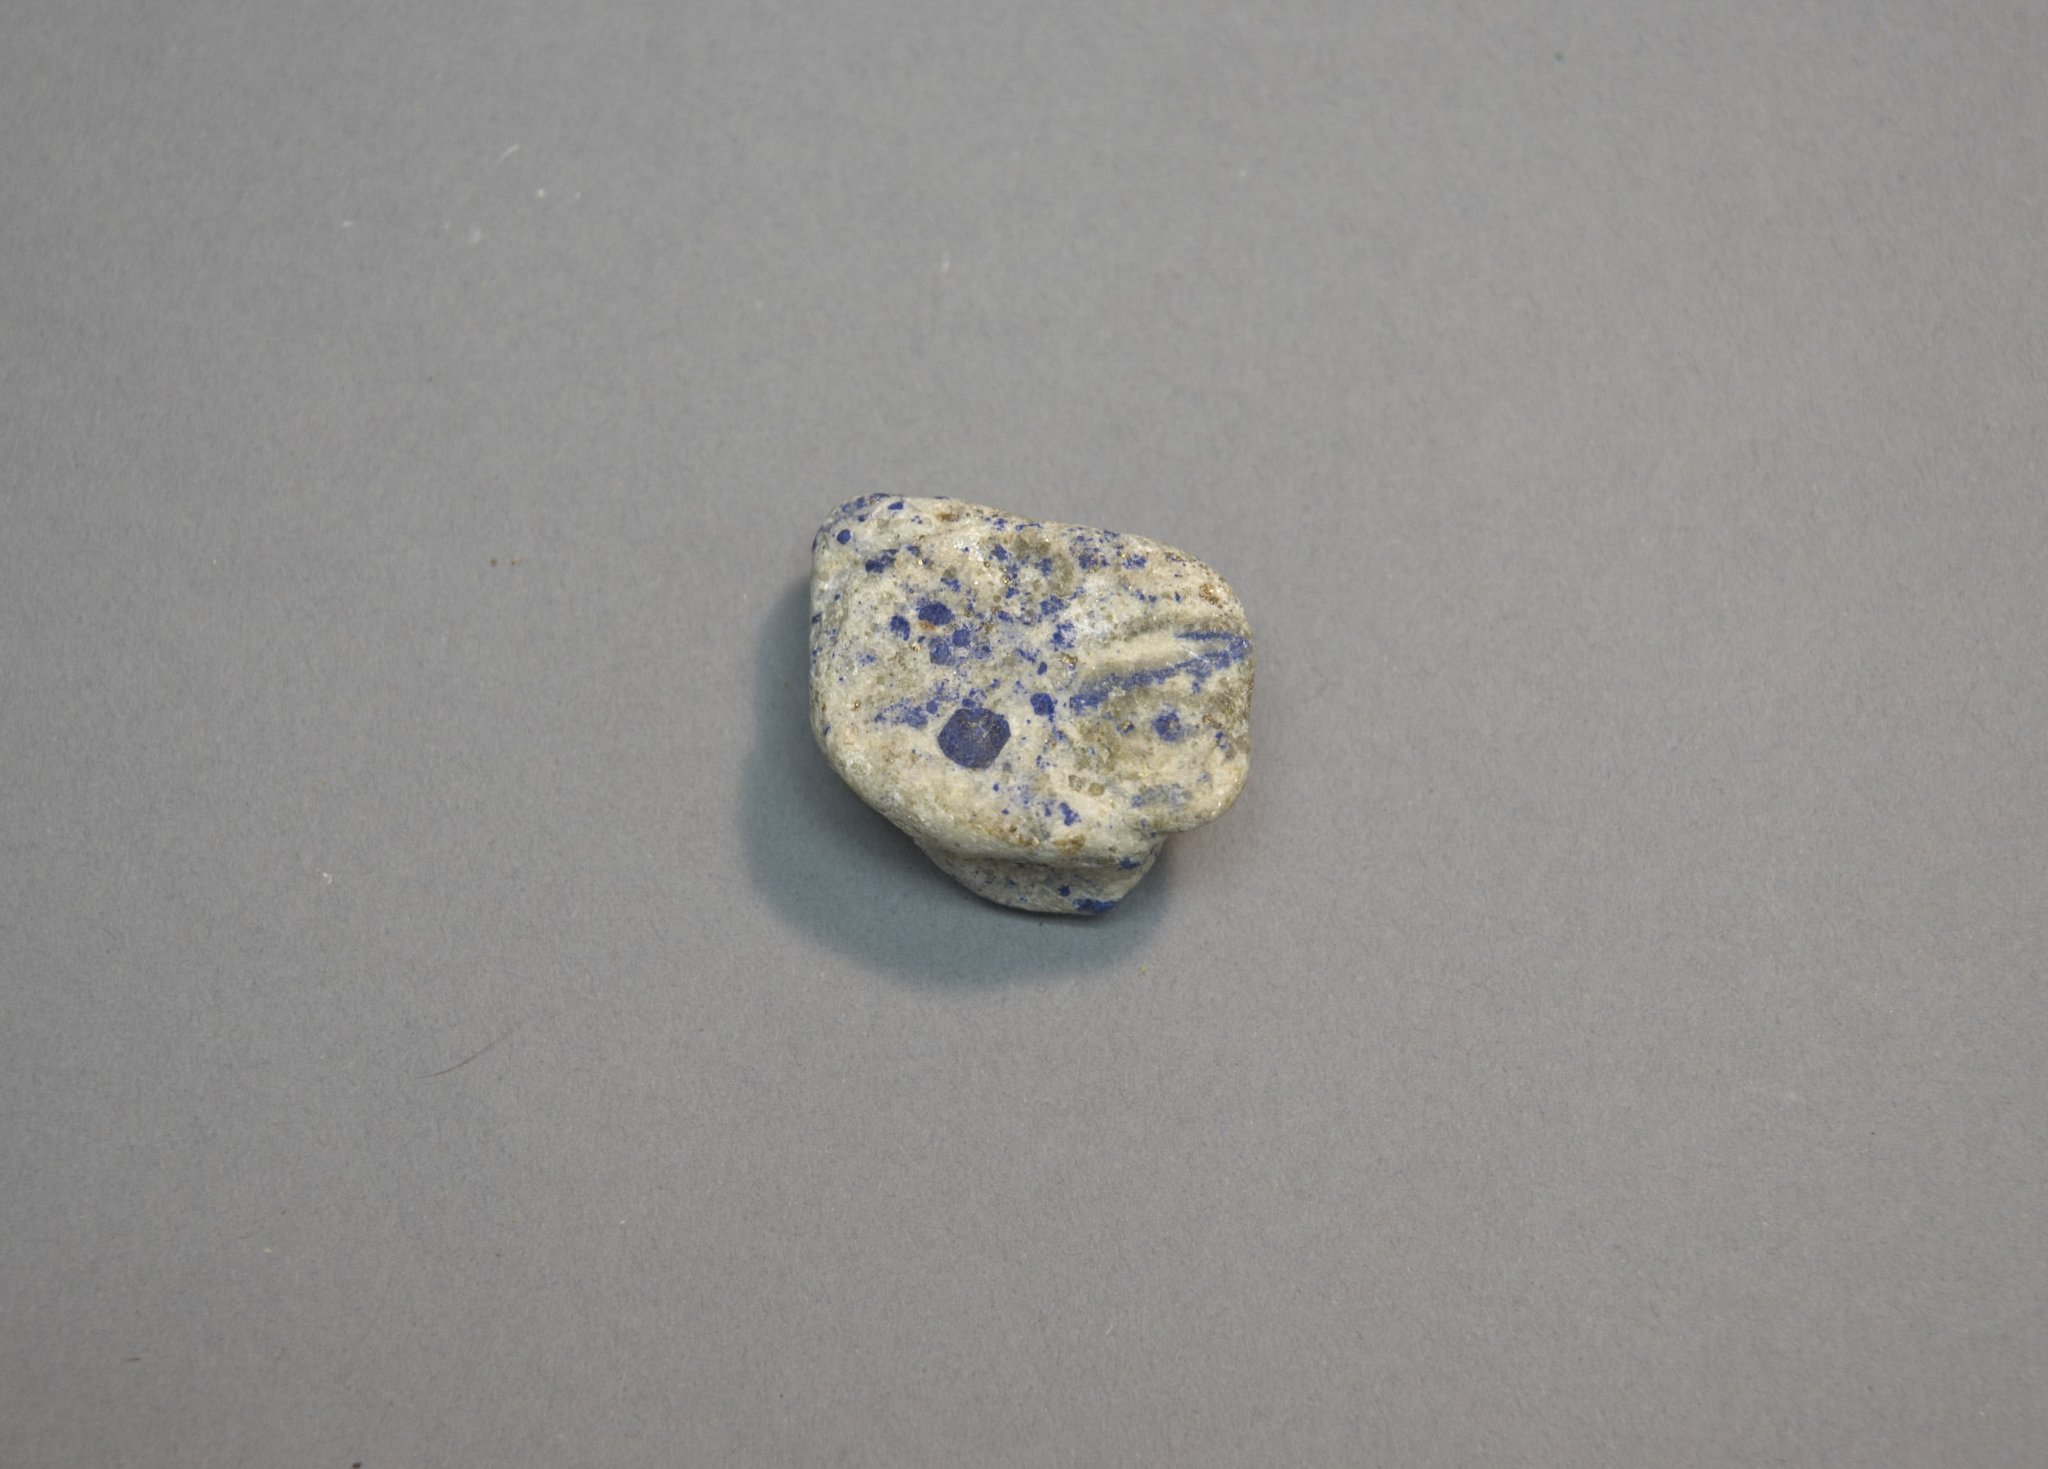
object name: jade carving material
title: Sample of Lapis Lazuli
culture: chinese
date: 1901-2000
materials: lapis lazuli